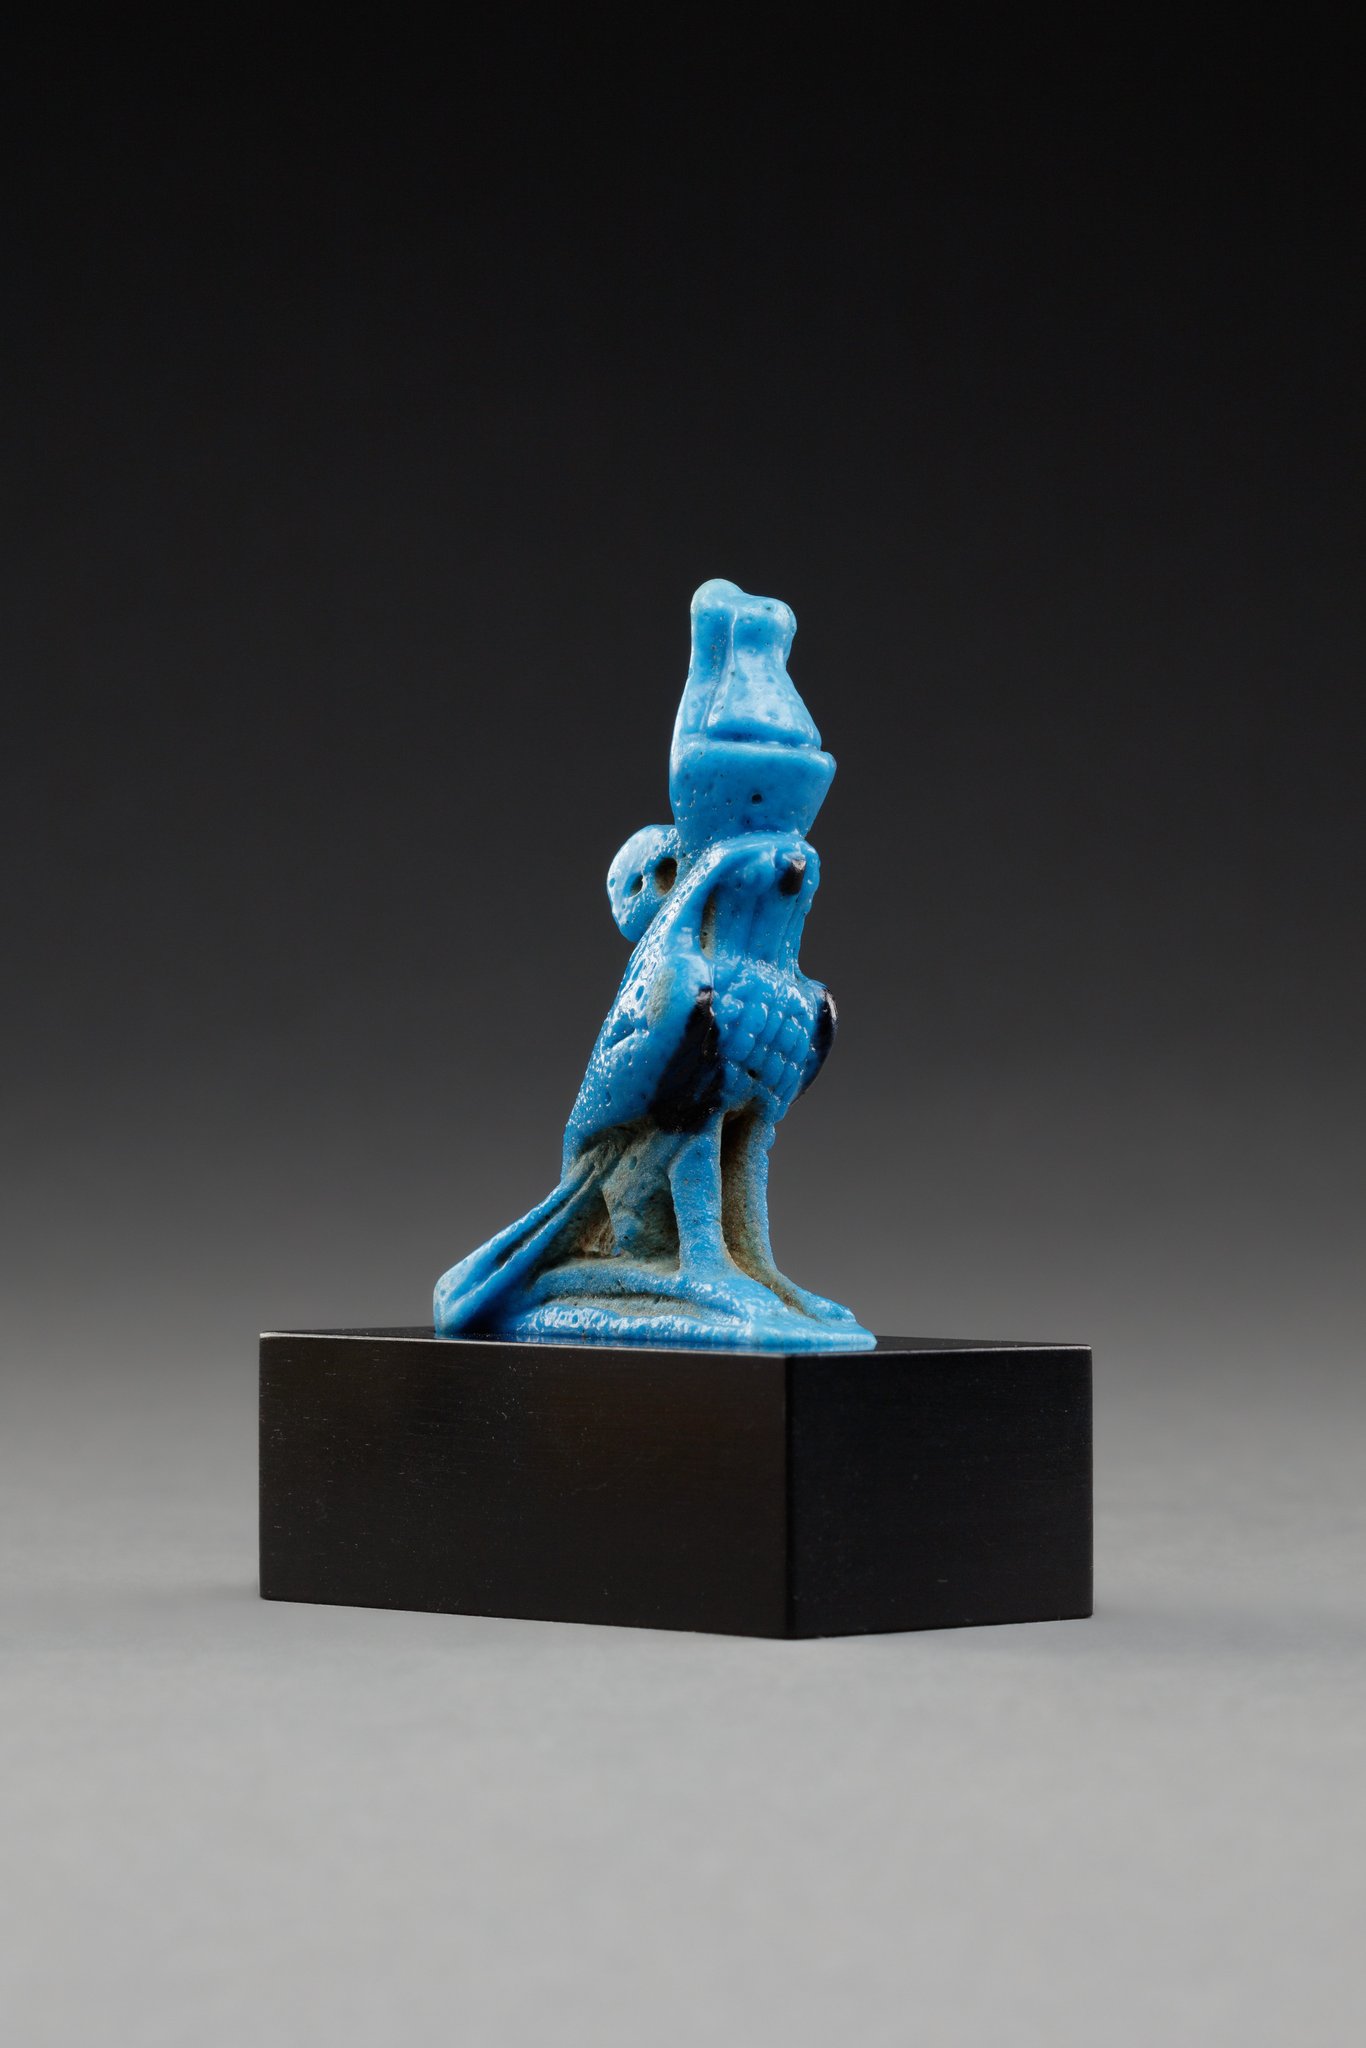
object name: horus amulet in the shape of a falcon with the double crown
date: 1070-664 BCE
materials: faience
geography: egypt